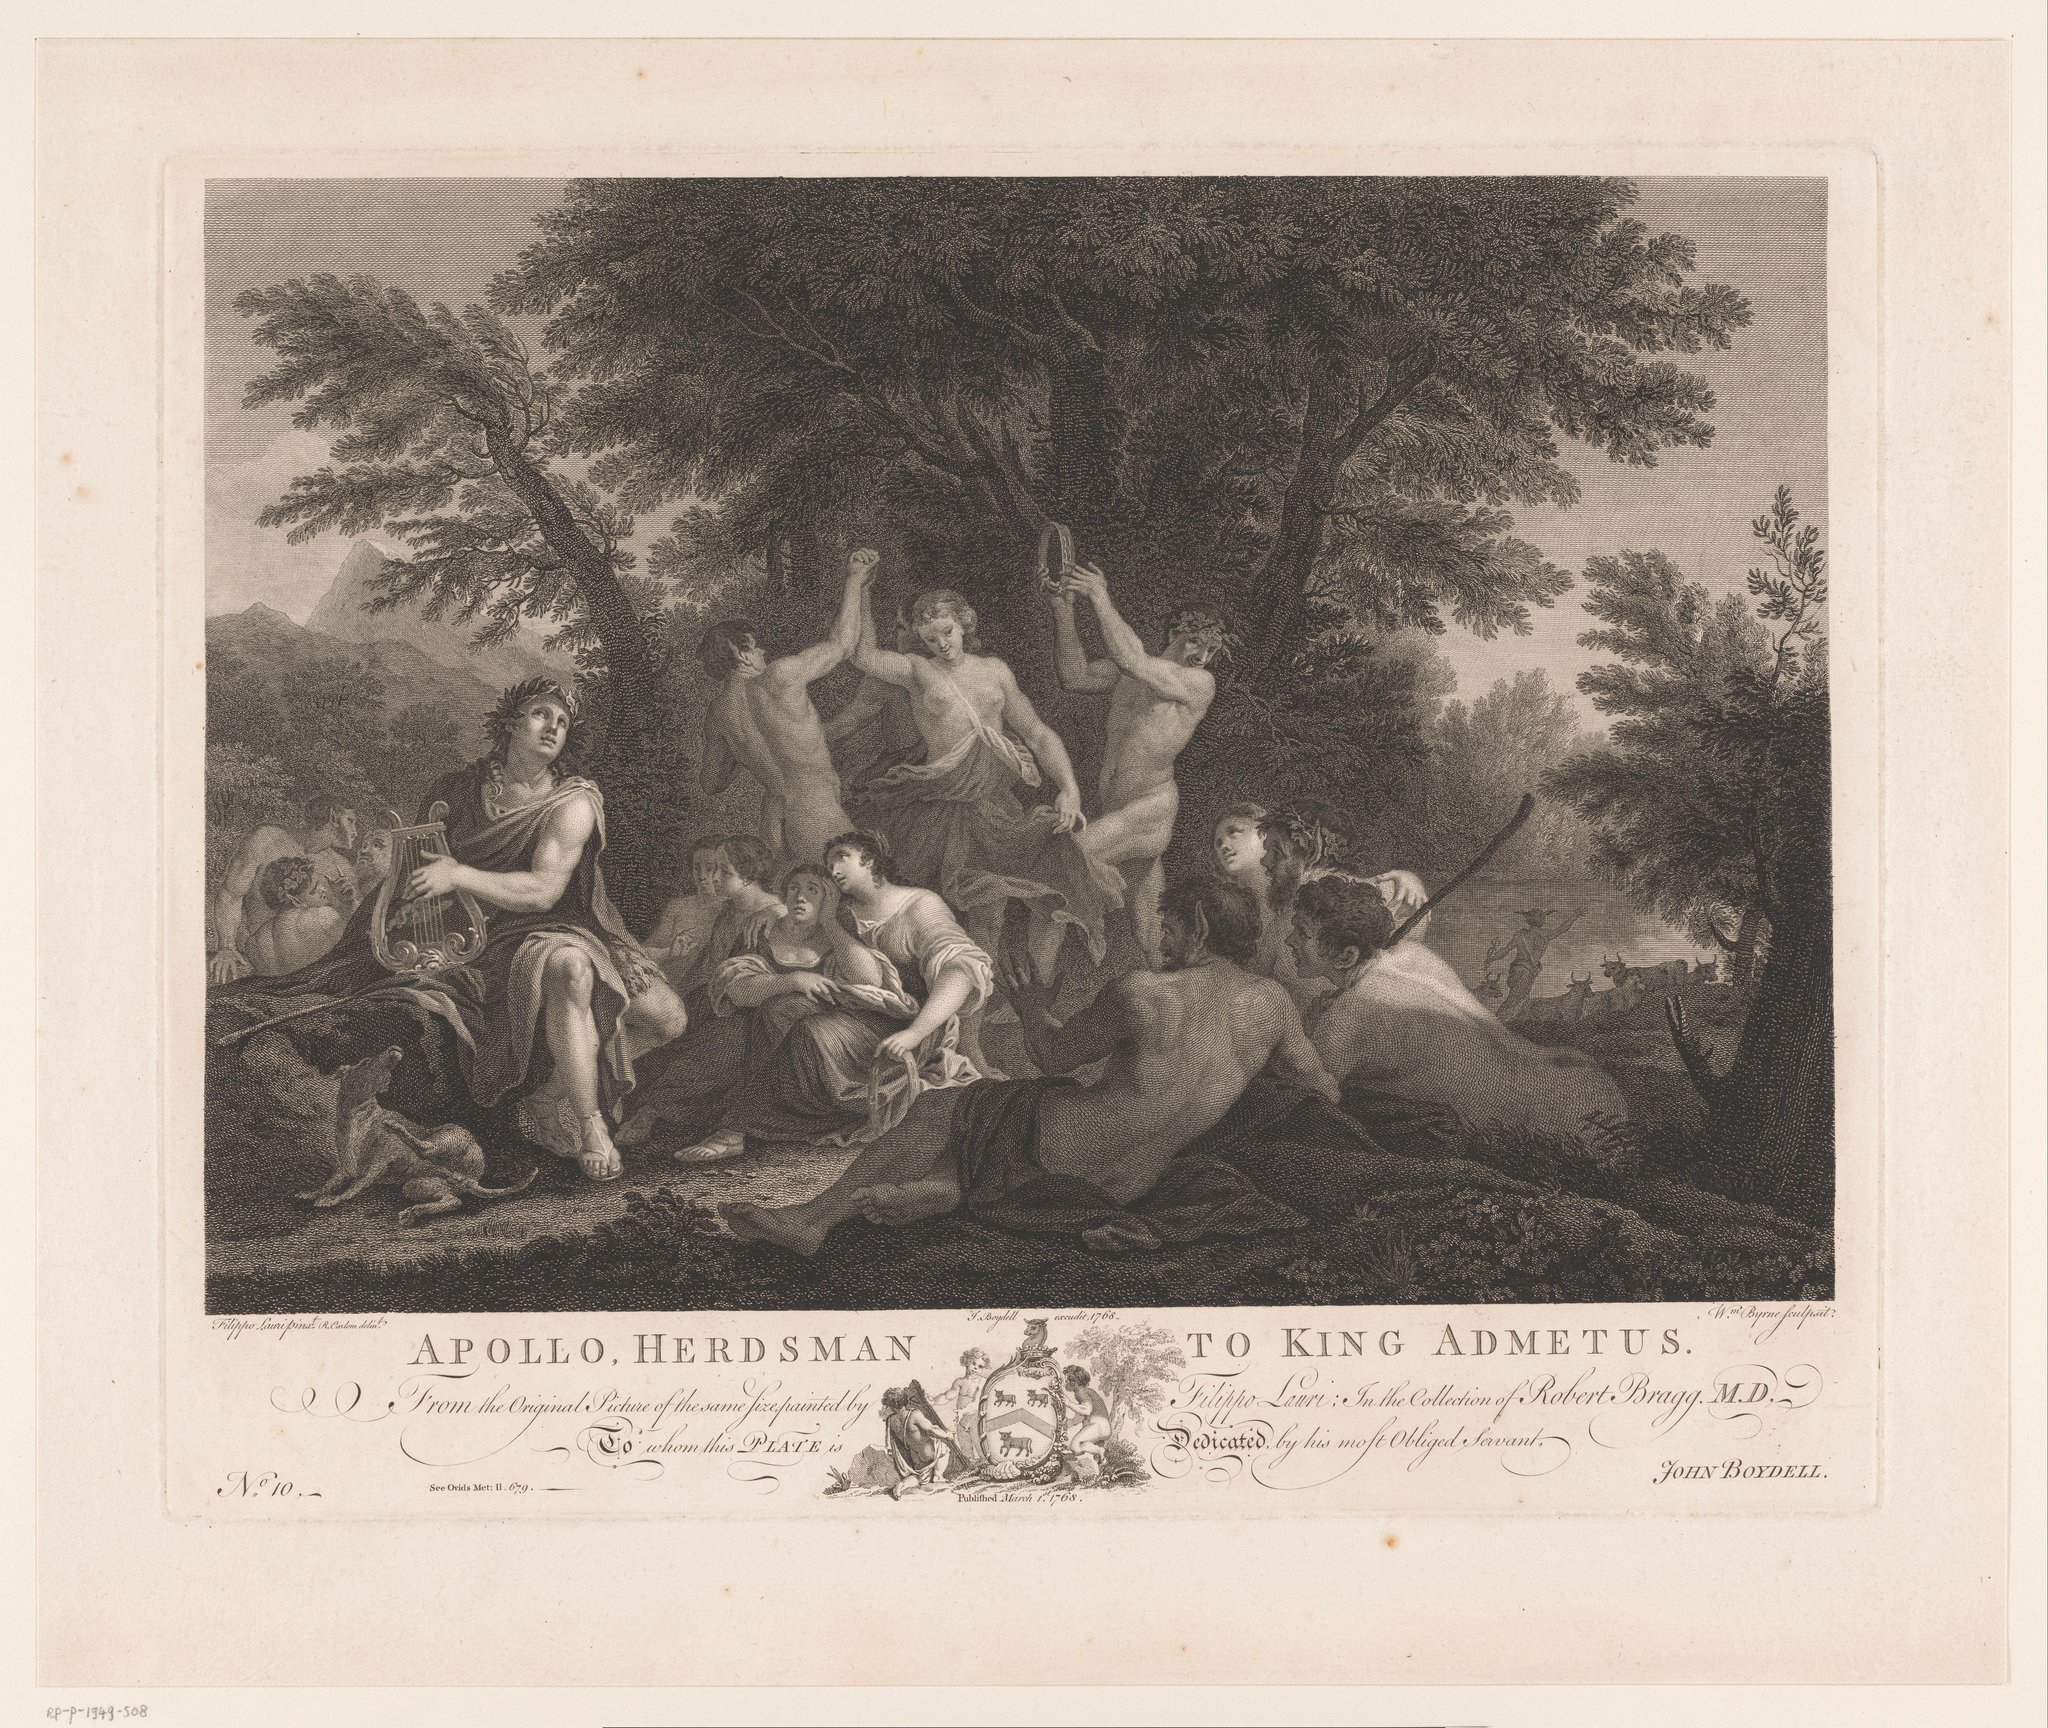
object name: print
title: Apollo als herder van koning Admetus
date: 1768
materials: paper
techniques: engraving, etching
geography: london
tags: (story of) apollo (phoebus), herding, herdsman, herdswoman, shepherd, shepherdess, cowherd, etc., musician - cc - out of doors, (story of) admetus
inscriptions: collector's mark: Lugt 2228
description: Tekst in het Engels in de ondermarge. Genummerd: 10.